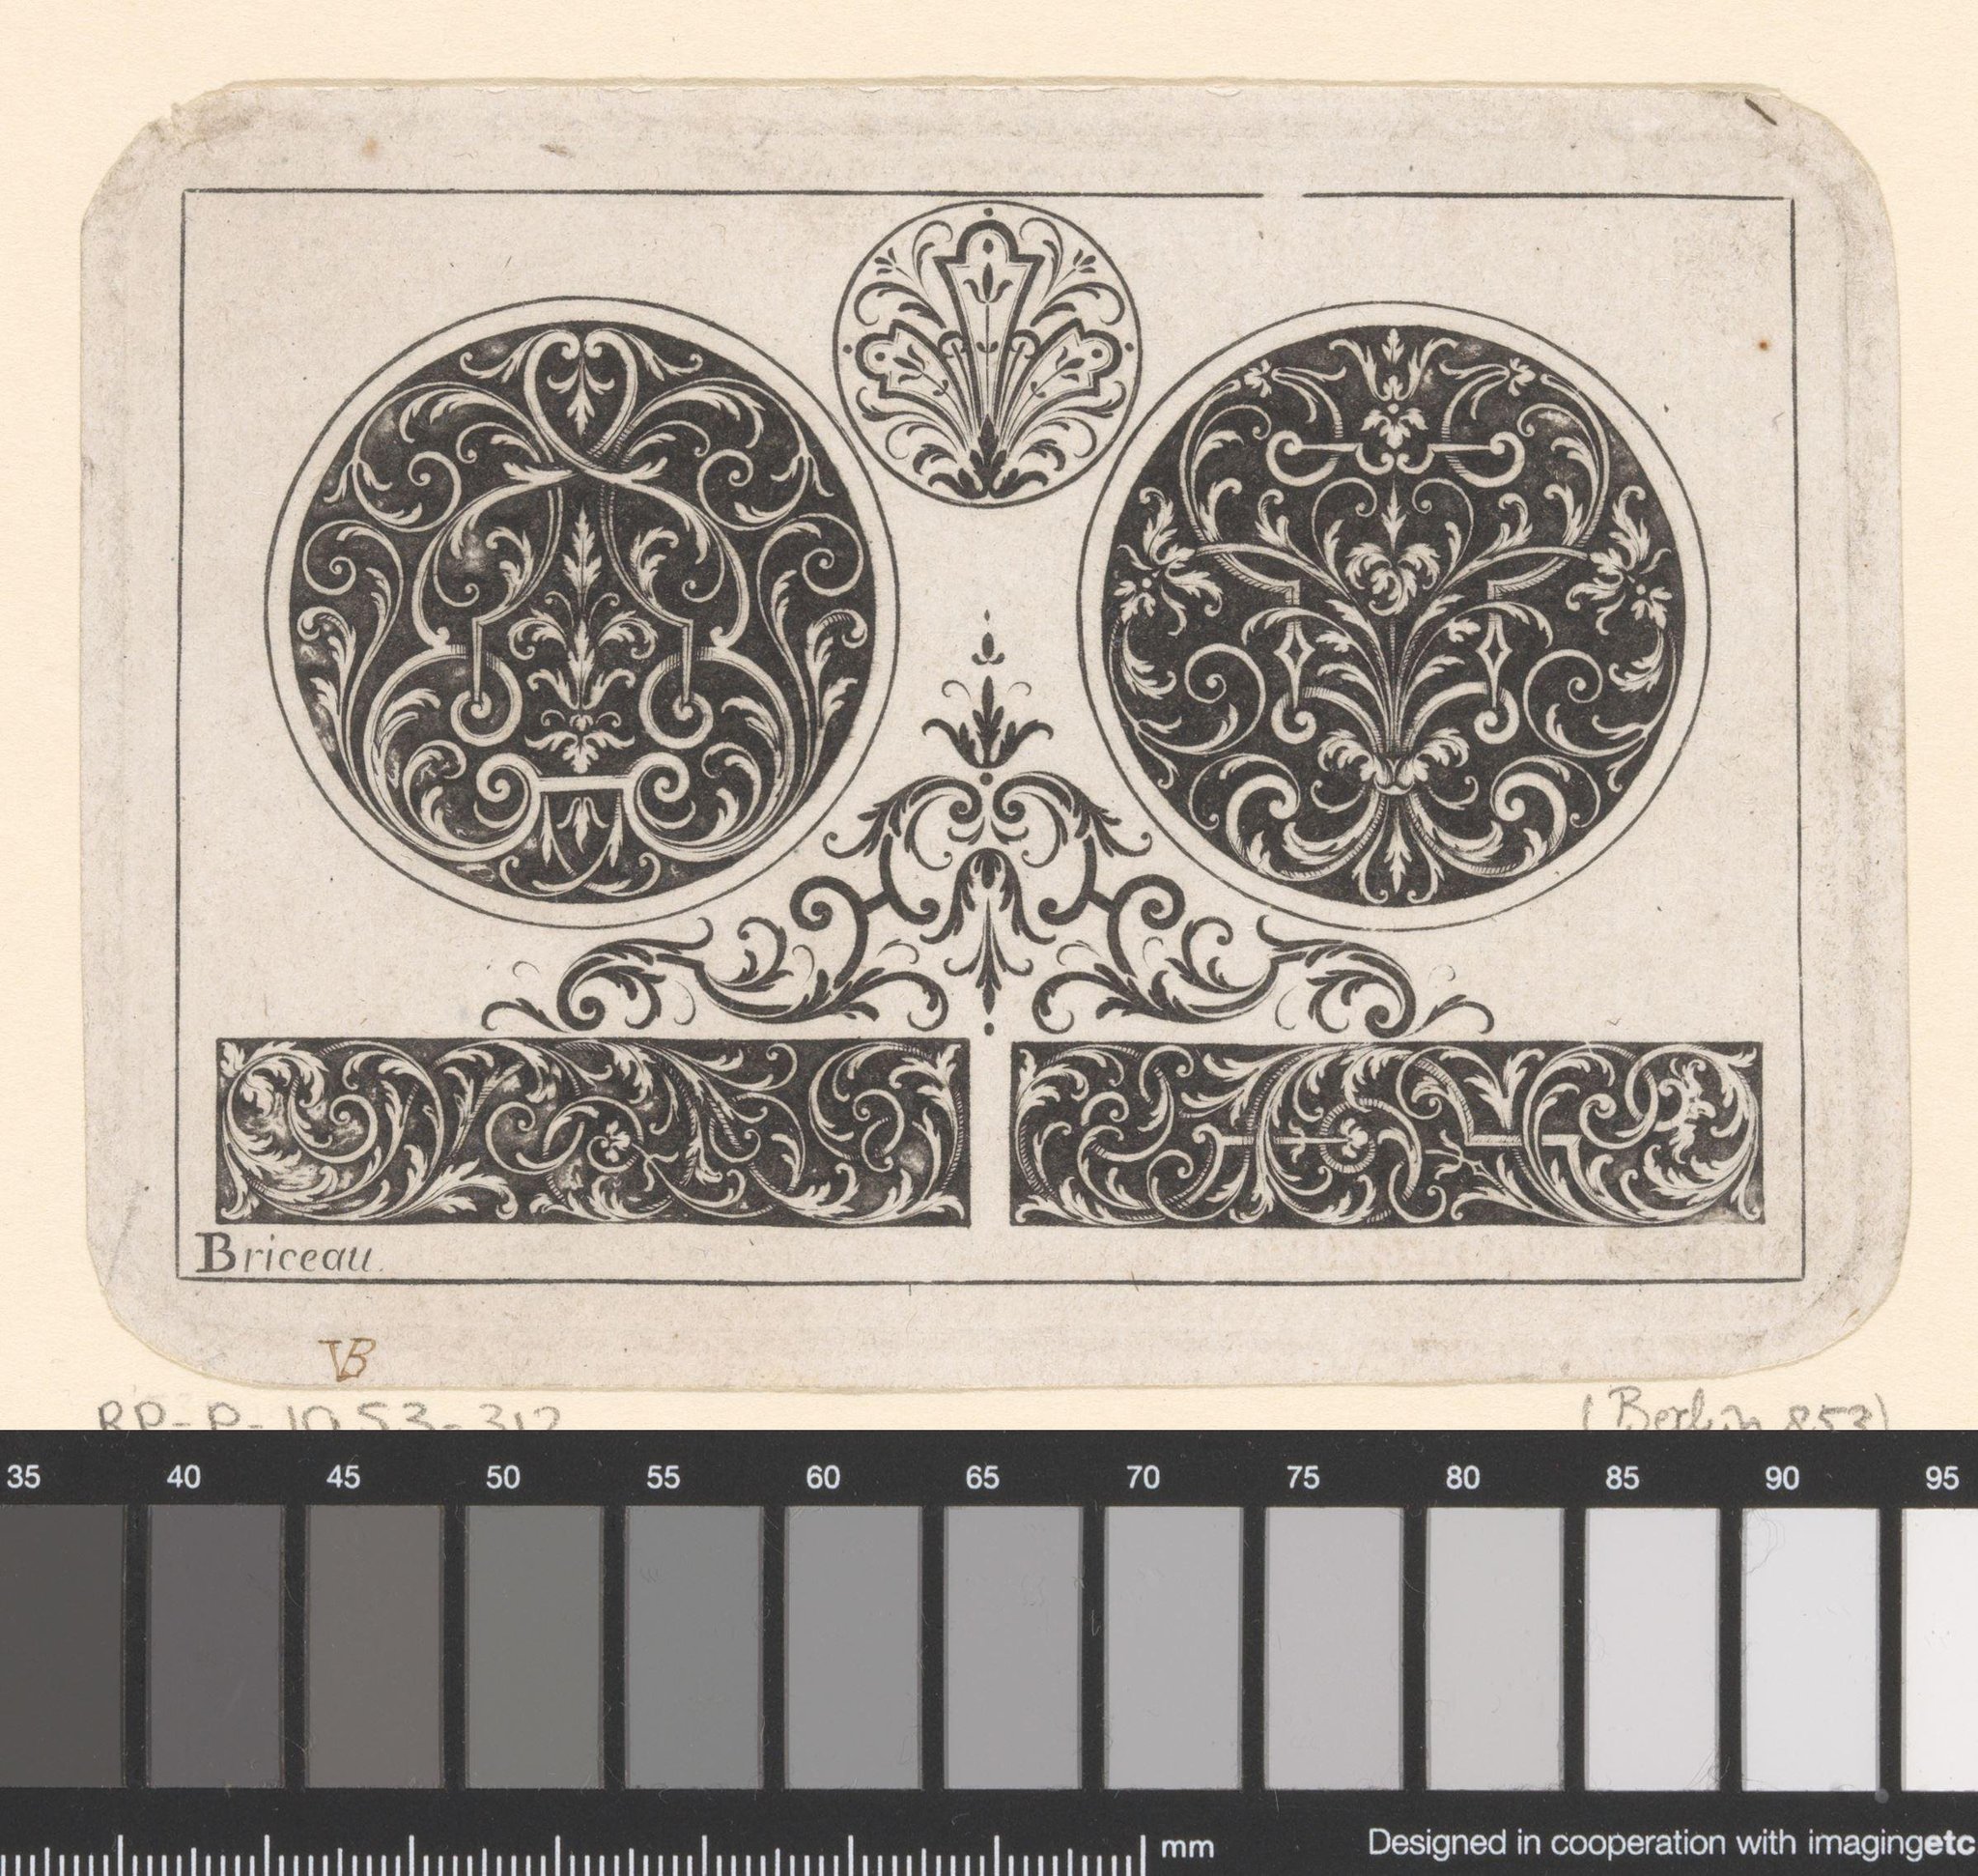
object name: print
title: Drie medaillons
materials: paper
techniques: etching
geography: paris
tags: interlace ~ ornament, ornament ~ medallion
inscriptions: collector's mark: Lugt 2228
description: Drie ronde medaillons gevuld met vlechtwerk, daaronder een ornament en twee rechthoeken gevuld met vlechtwerk.